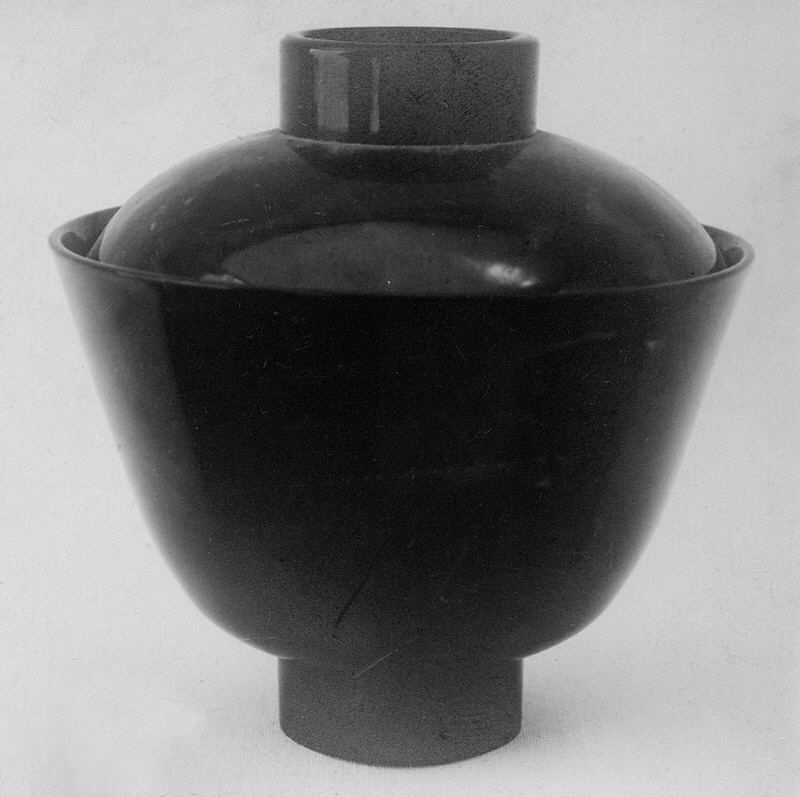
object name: cup with cover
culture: chinese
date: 1801-1900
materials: shell